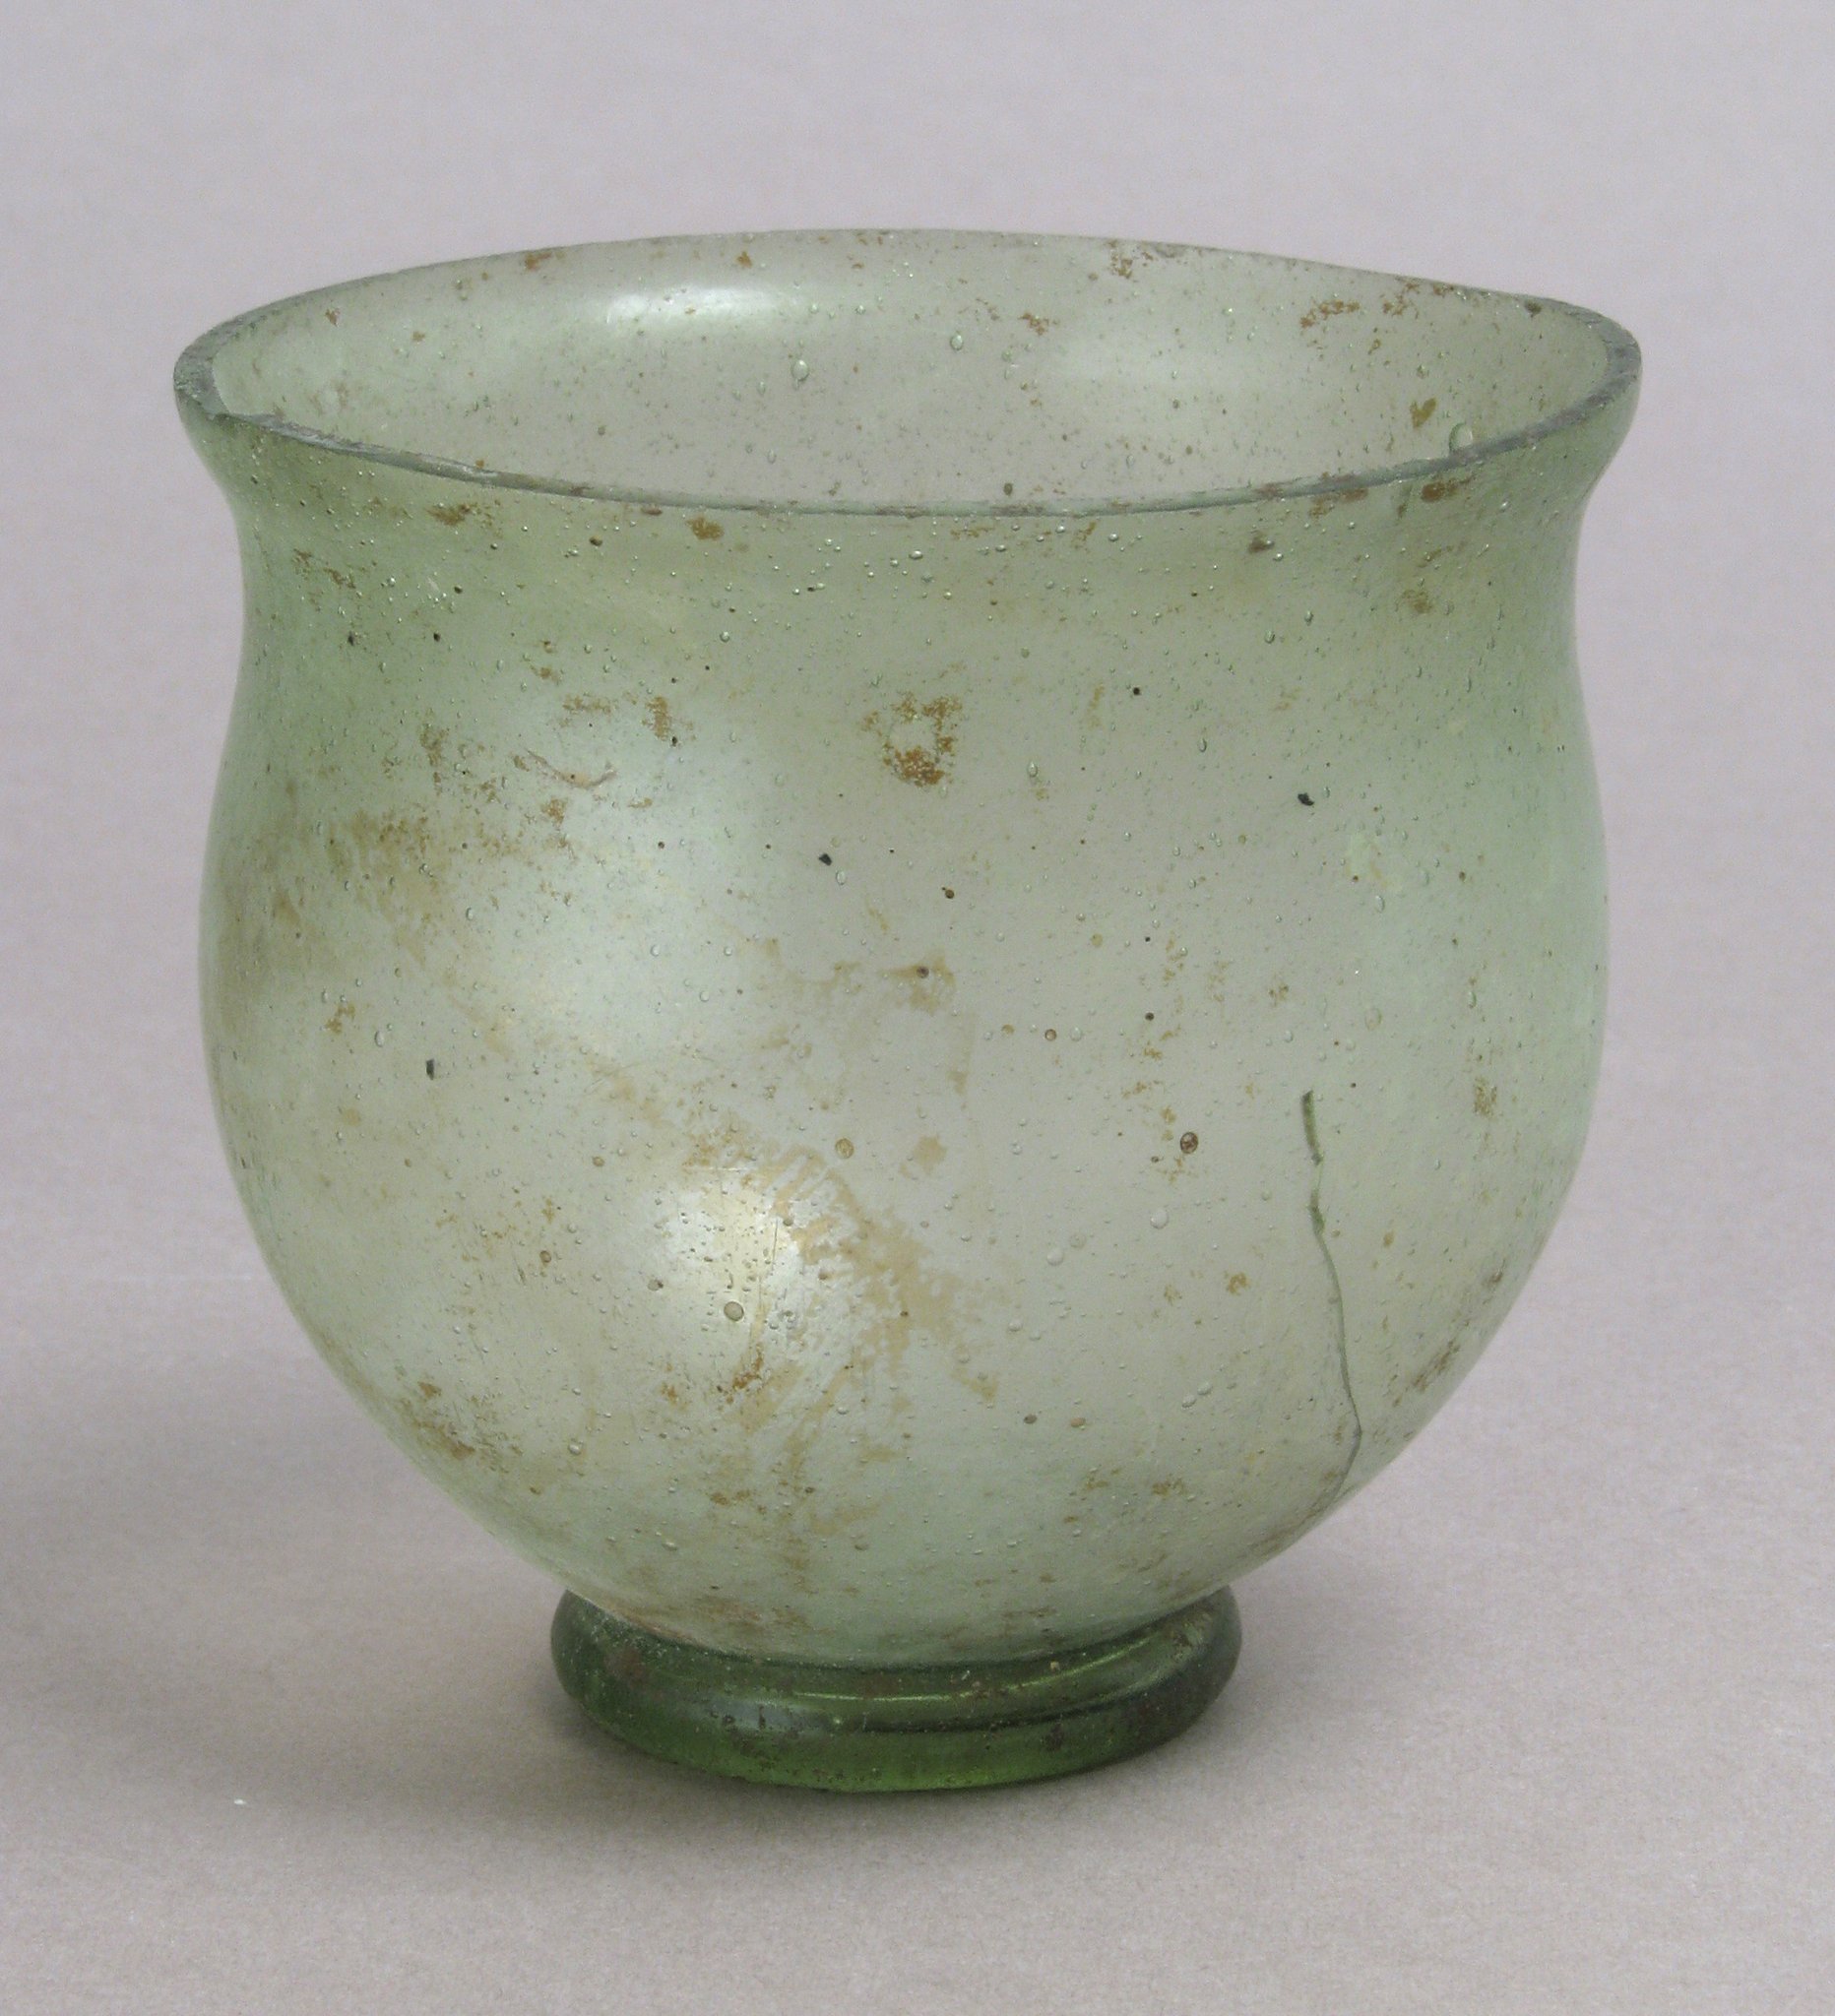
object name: bowl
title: Footed Bowl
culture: frankish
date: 367-433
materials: glass